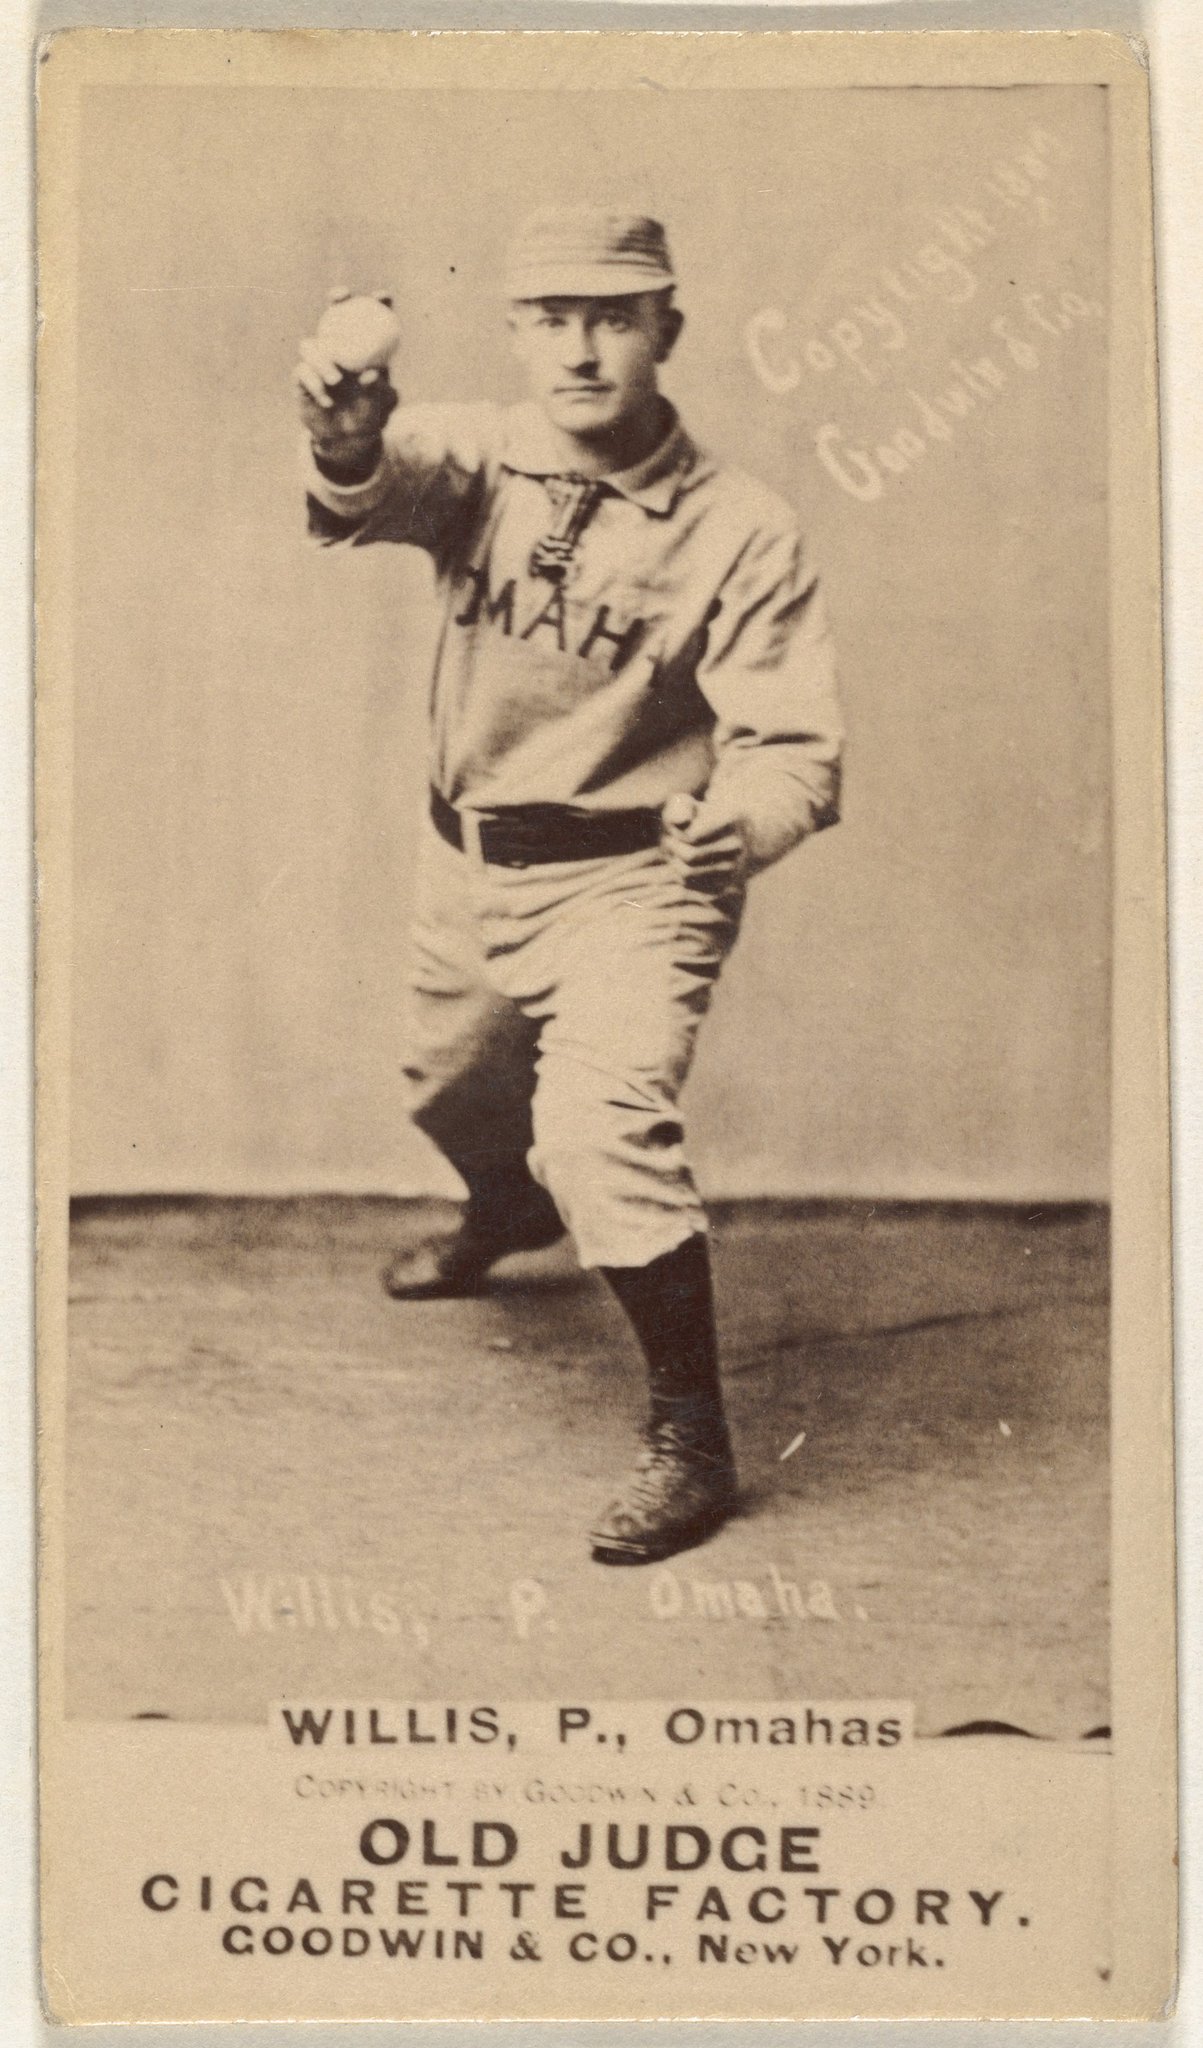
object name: baseball card, photograph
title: Willis, Pitcher, Omaha Omahogs/ Lambs, from the Old Judge series (N172) for Old Judge Cigarettes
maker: goodwin & company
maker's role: publisher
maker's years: 1850-1950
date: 1889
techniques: albumen silver print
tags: men,portraits,baseball,athletes